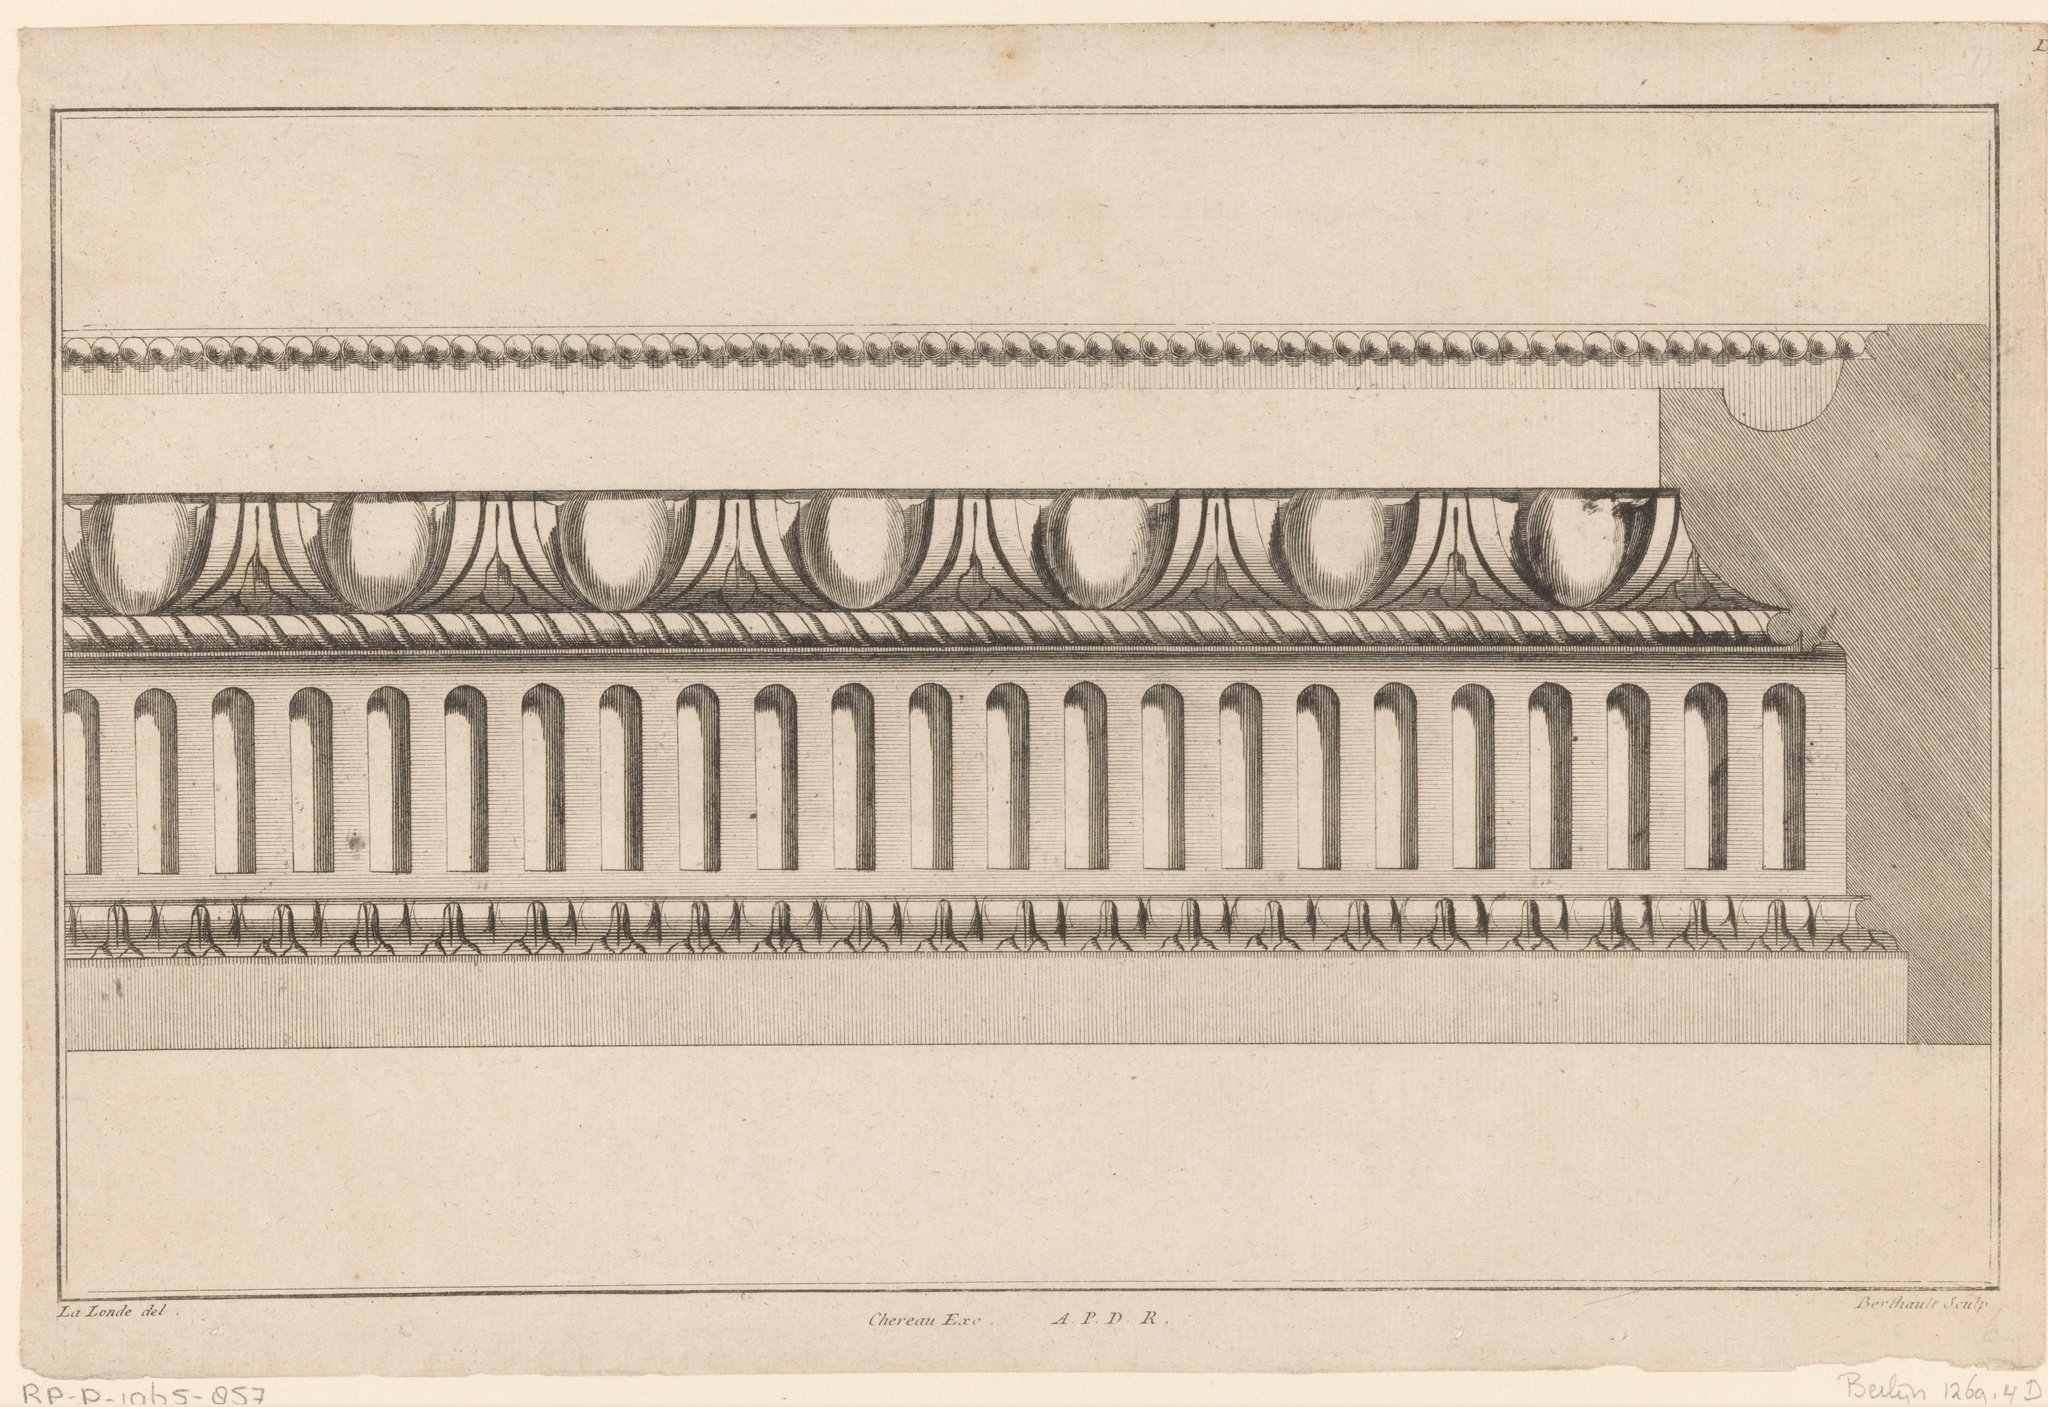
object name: ornament print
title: 4e Cahier de l'Oeuvre D Cahier de Bordures à l'usage de la Sculpture &c, avec leurs Profils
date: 1784-1785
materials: paper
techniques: engraving, etching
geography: paris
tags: ornaments ~ art (+ framing decorations)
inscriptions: collector's mark: Lugt 2760, collector's mark: Lugt 2228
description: Een geornamenteerde lijst met eierlijst.